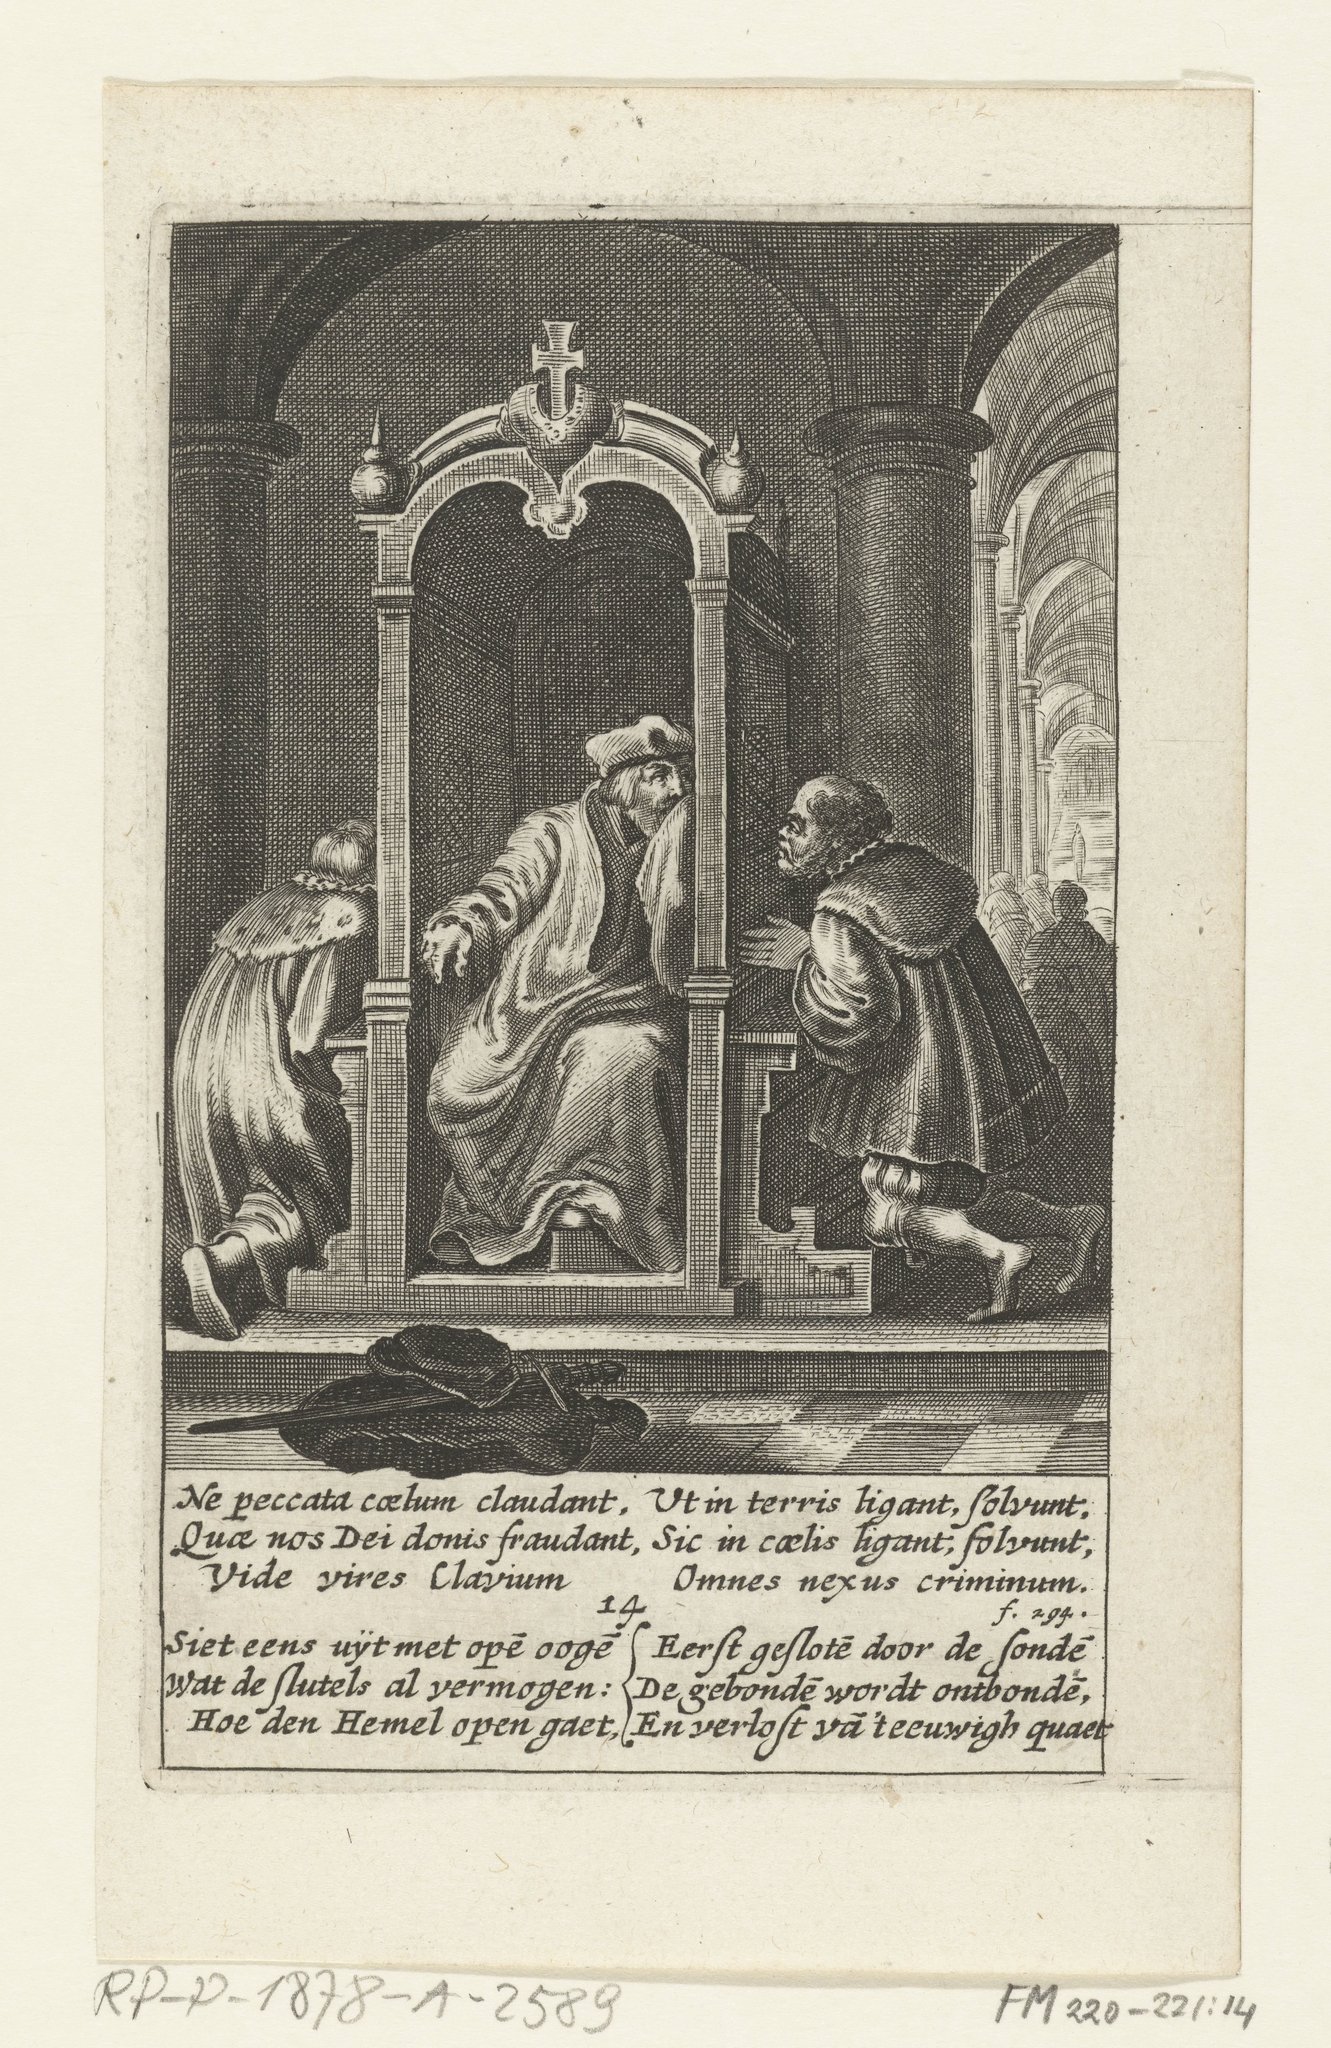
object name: print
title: Het Mirakel van Amsterdam, 1345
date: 1639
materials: paper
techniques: engraving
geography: southern netherlands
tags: confession; 'confessione sacramentale' (ripa) ~ the third of the seven sacraments, amsterdam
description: Een priester neemt de biecht af. Prent nr. 14 uit de serie van 16 voorstellingen van Het Mirakel van Amsterdam, naar de gebeurtenissen op 15 maart 1345. Onder de voorstelling twee zesregelige verzen in het Latijn en Nederlands.